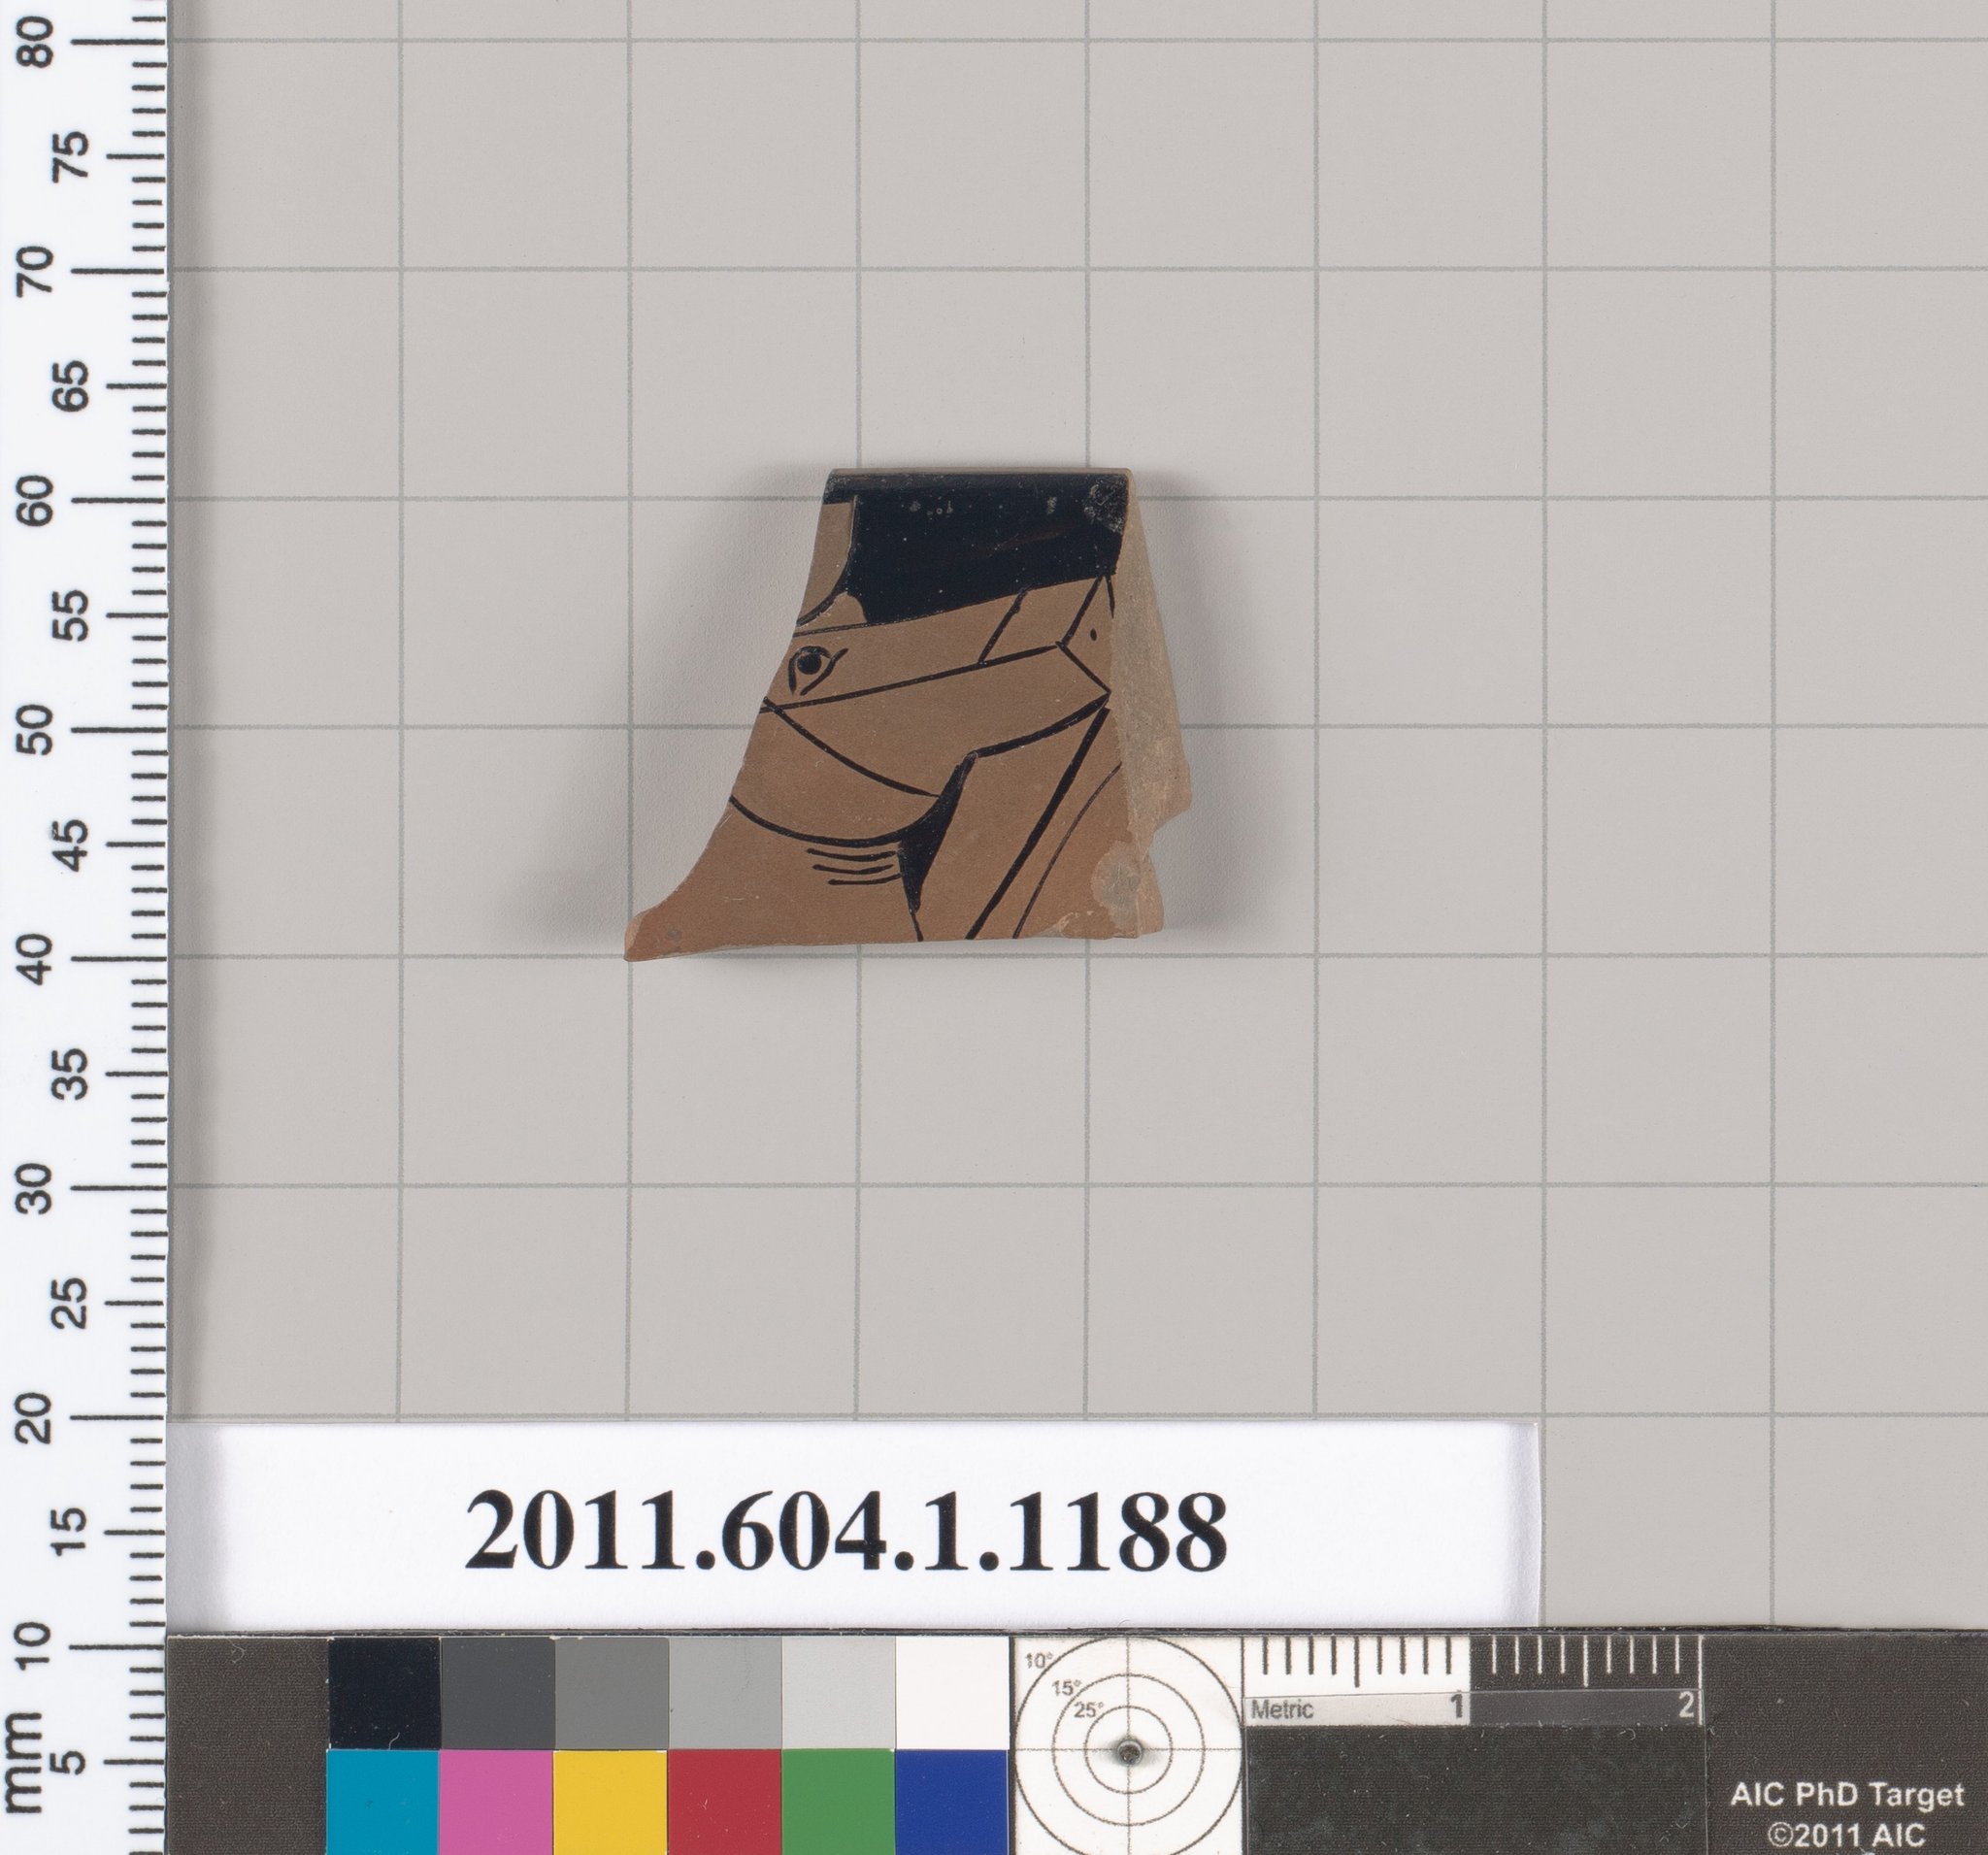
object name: kylix fragment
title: Terracotta rim fragment of a kylix (drinking cup)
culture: greek, attic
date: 490-480 BCE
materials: terracotta